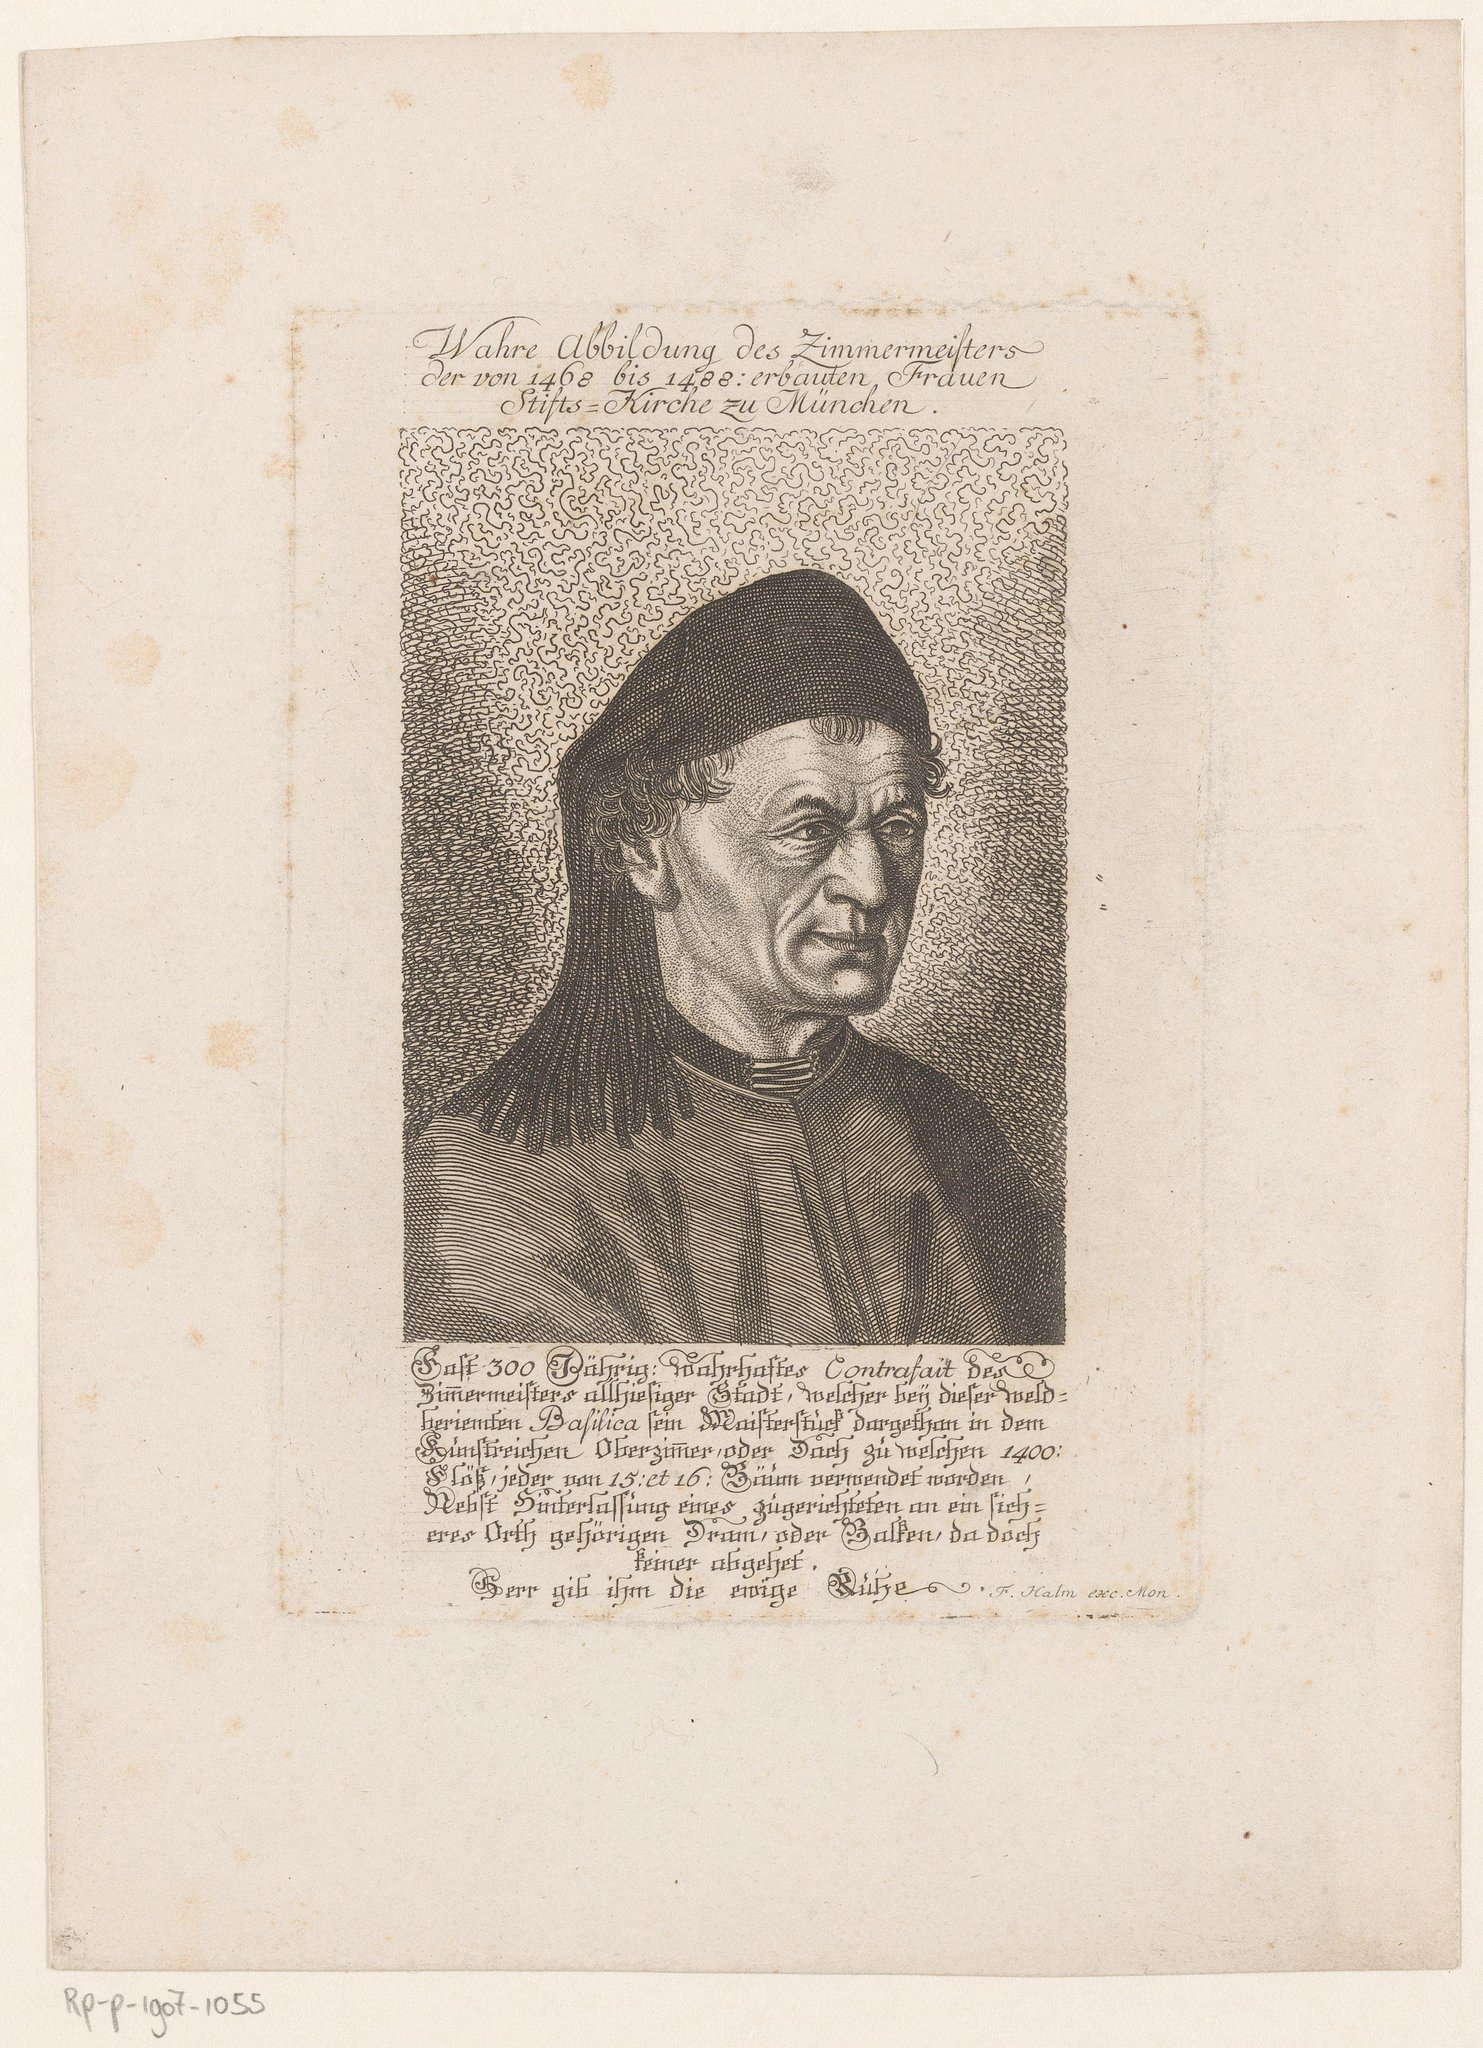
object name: print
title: Portret van Jörg von Halsbach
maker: felix halm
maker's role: painter, print maker, publisher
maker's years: 1758-1810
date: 1768-1810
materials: paper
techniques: etching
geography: munich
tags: historical persons, portrait, self-portrait of architect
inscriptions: collector's mark: Lugt 2228